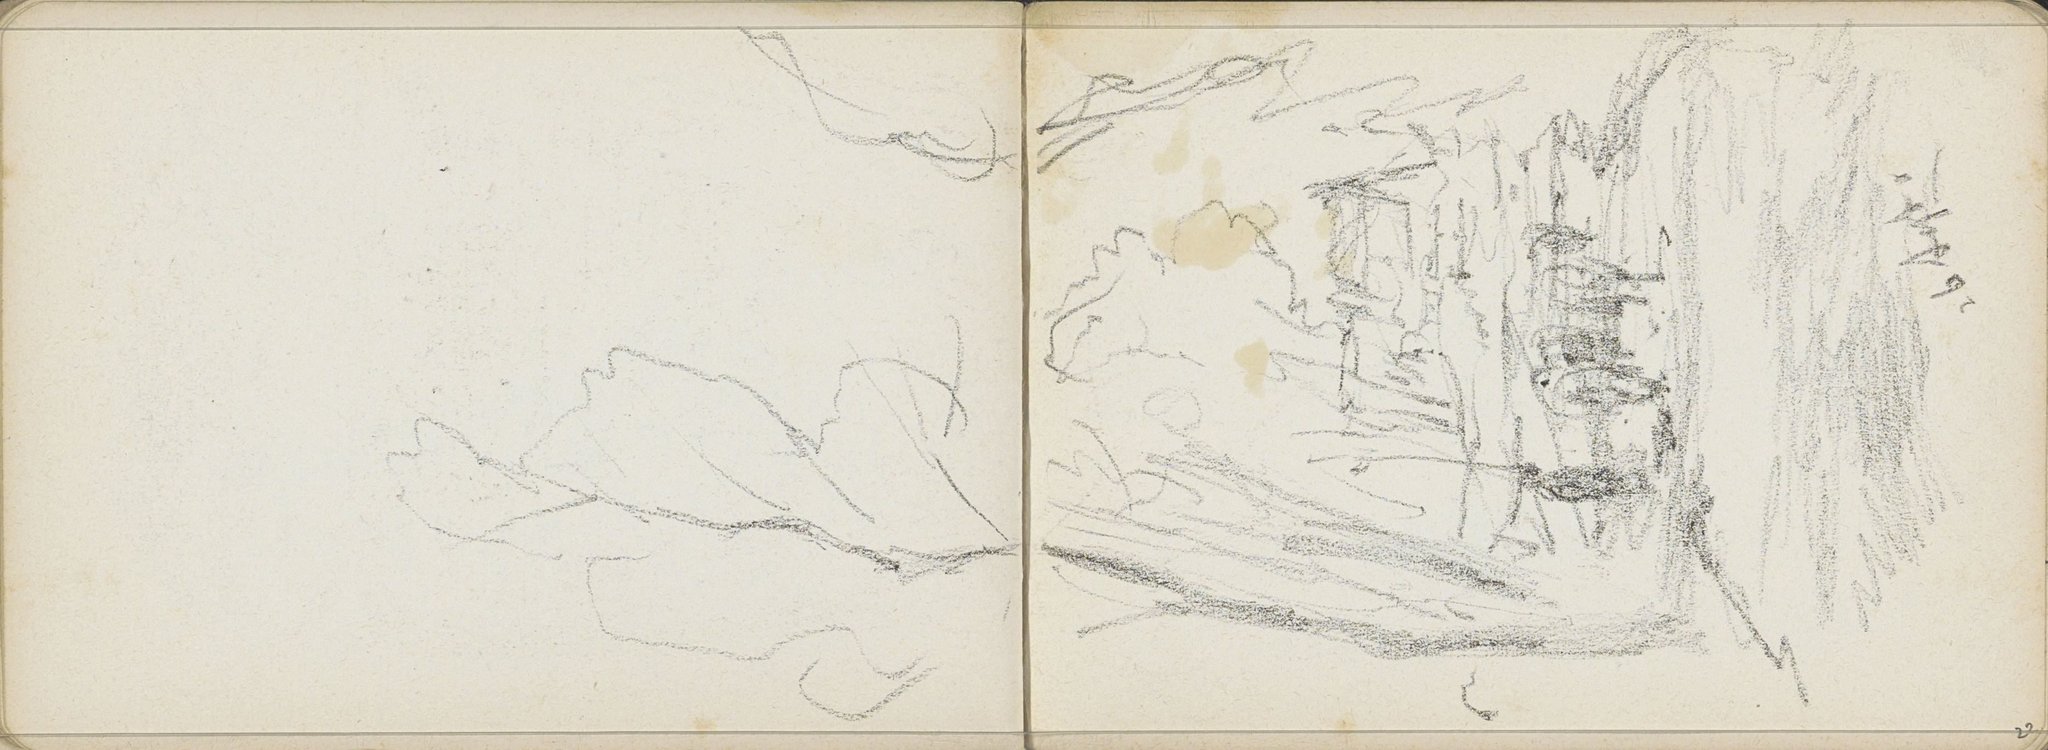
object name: sketchbook leaf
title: Man met vee op een pad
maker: willem cornelis rip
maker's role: draughtsman, painter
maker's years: 1856-1922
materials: chalk, paper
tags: cattle, road, path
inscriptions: date: ‘26 Sept.’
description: Blad 21 verso en 22 recto uit een schetsboek met 42 bladen.